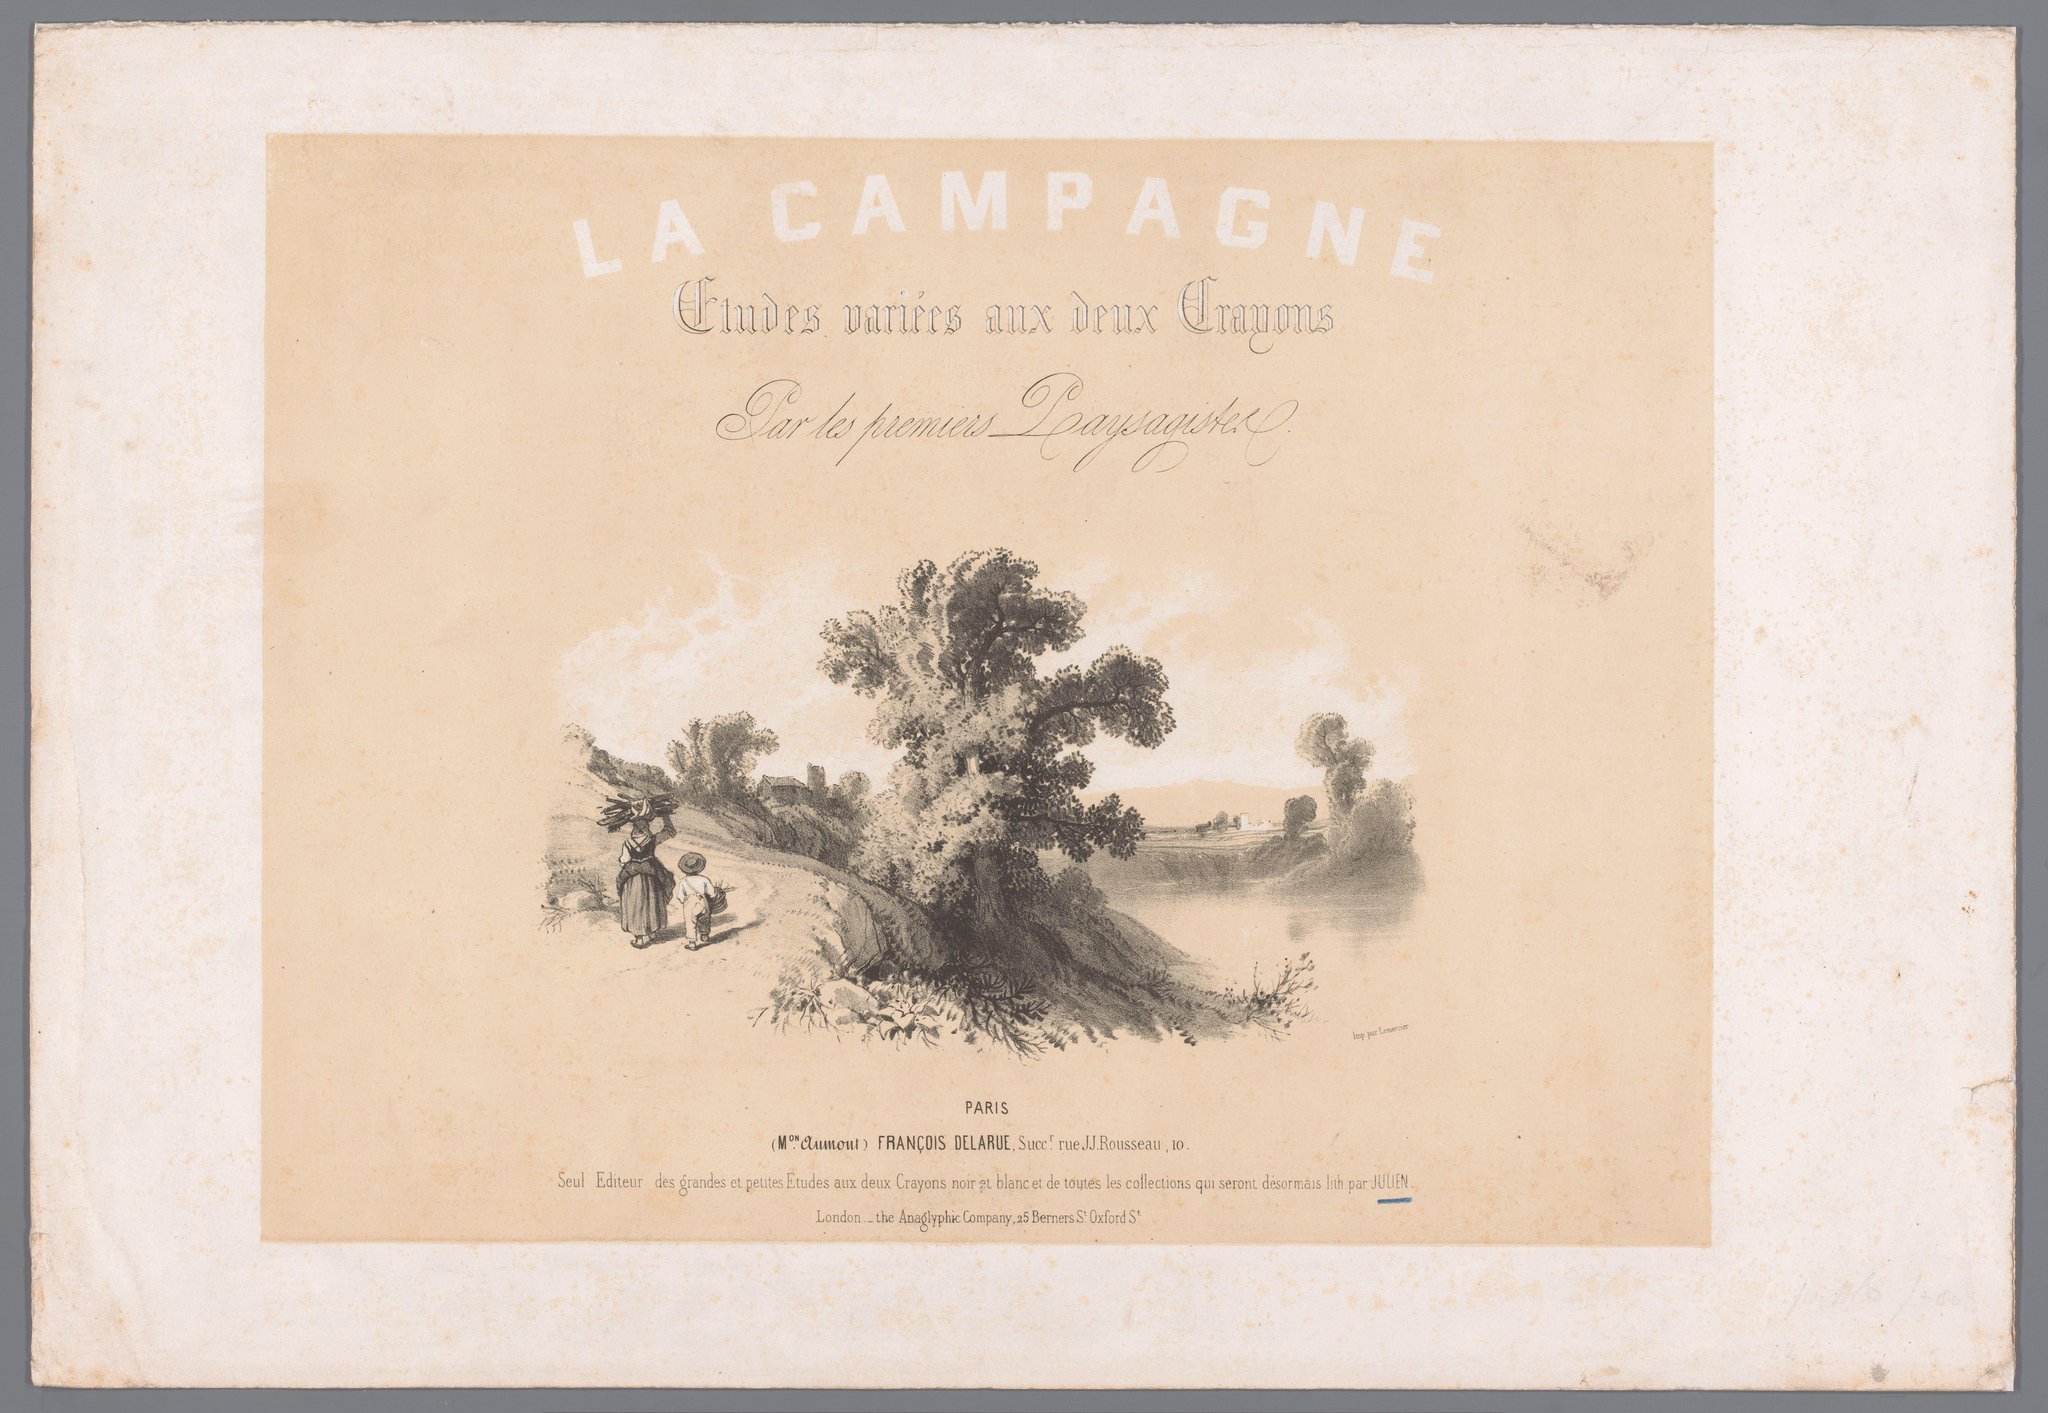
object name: wrapper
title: Omslag voor zes prenten met voorstellingen van het leven op het platteland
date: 1844-1845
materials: paper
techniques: tone lithography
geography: paris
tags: trees, road, path, river (+ landscape with figures, staffage)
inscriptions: collector's mark: Lugt 2228a